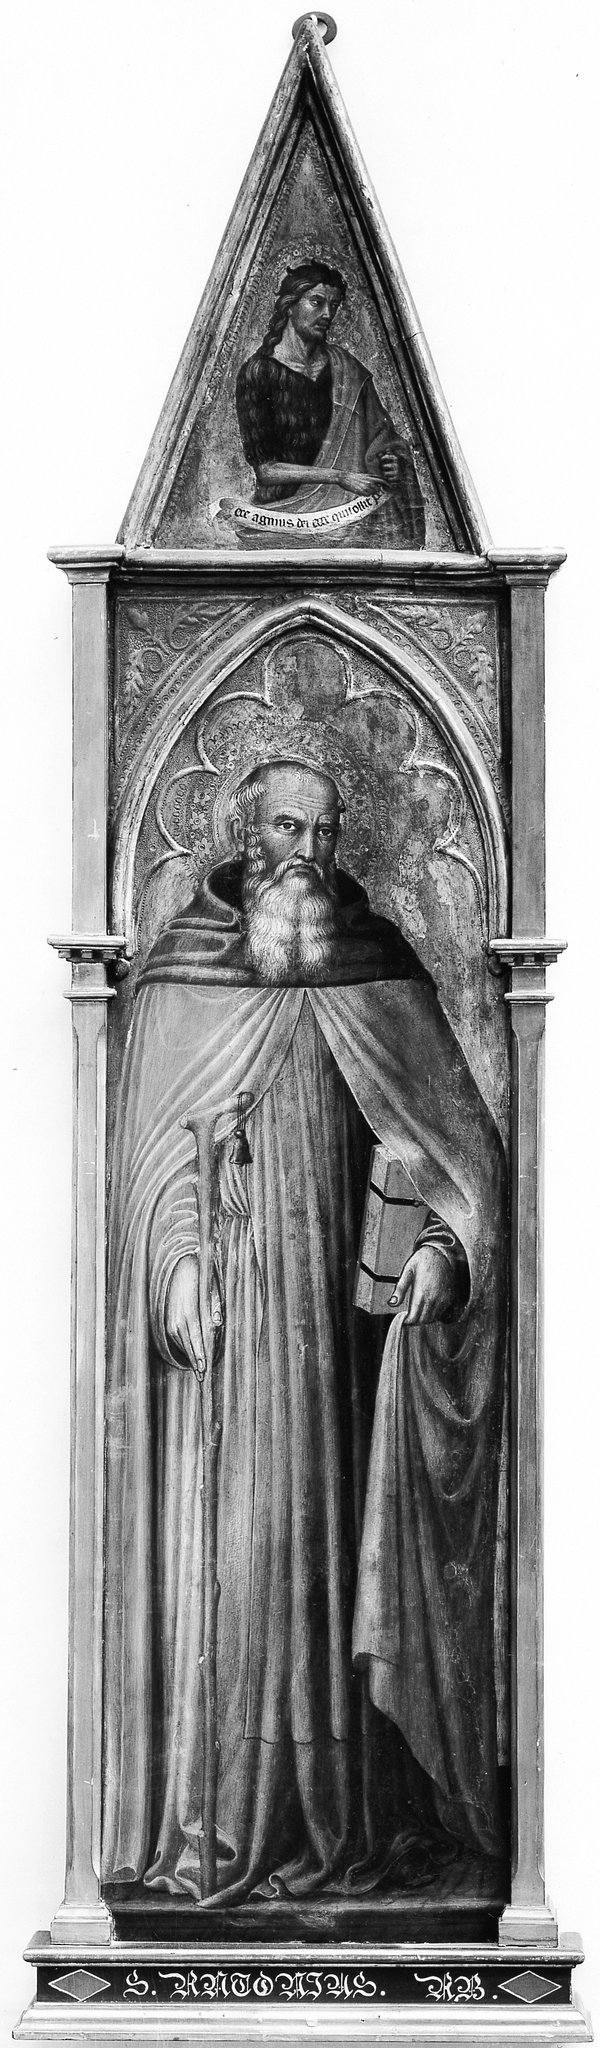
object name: painting, part of an altarpiece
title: Saint Anthony Abbot (with Saint John the Baptist)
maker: martino di bartolommeo di biagio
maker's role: artist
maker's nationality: italian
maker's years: 1389-1435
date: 1389-1435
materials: gold leaf, paint, wood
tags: men,saint john the baptist,saints